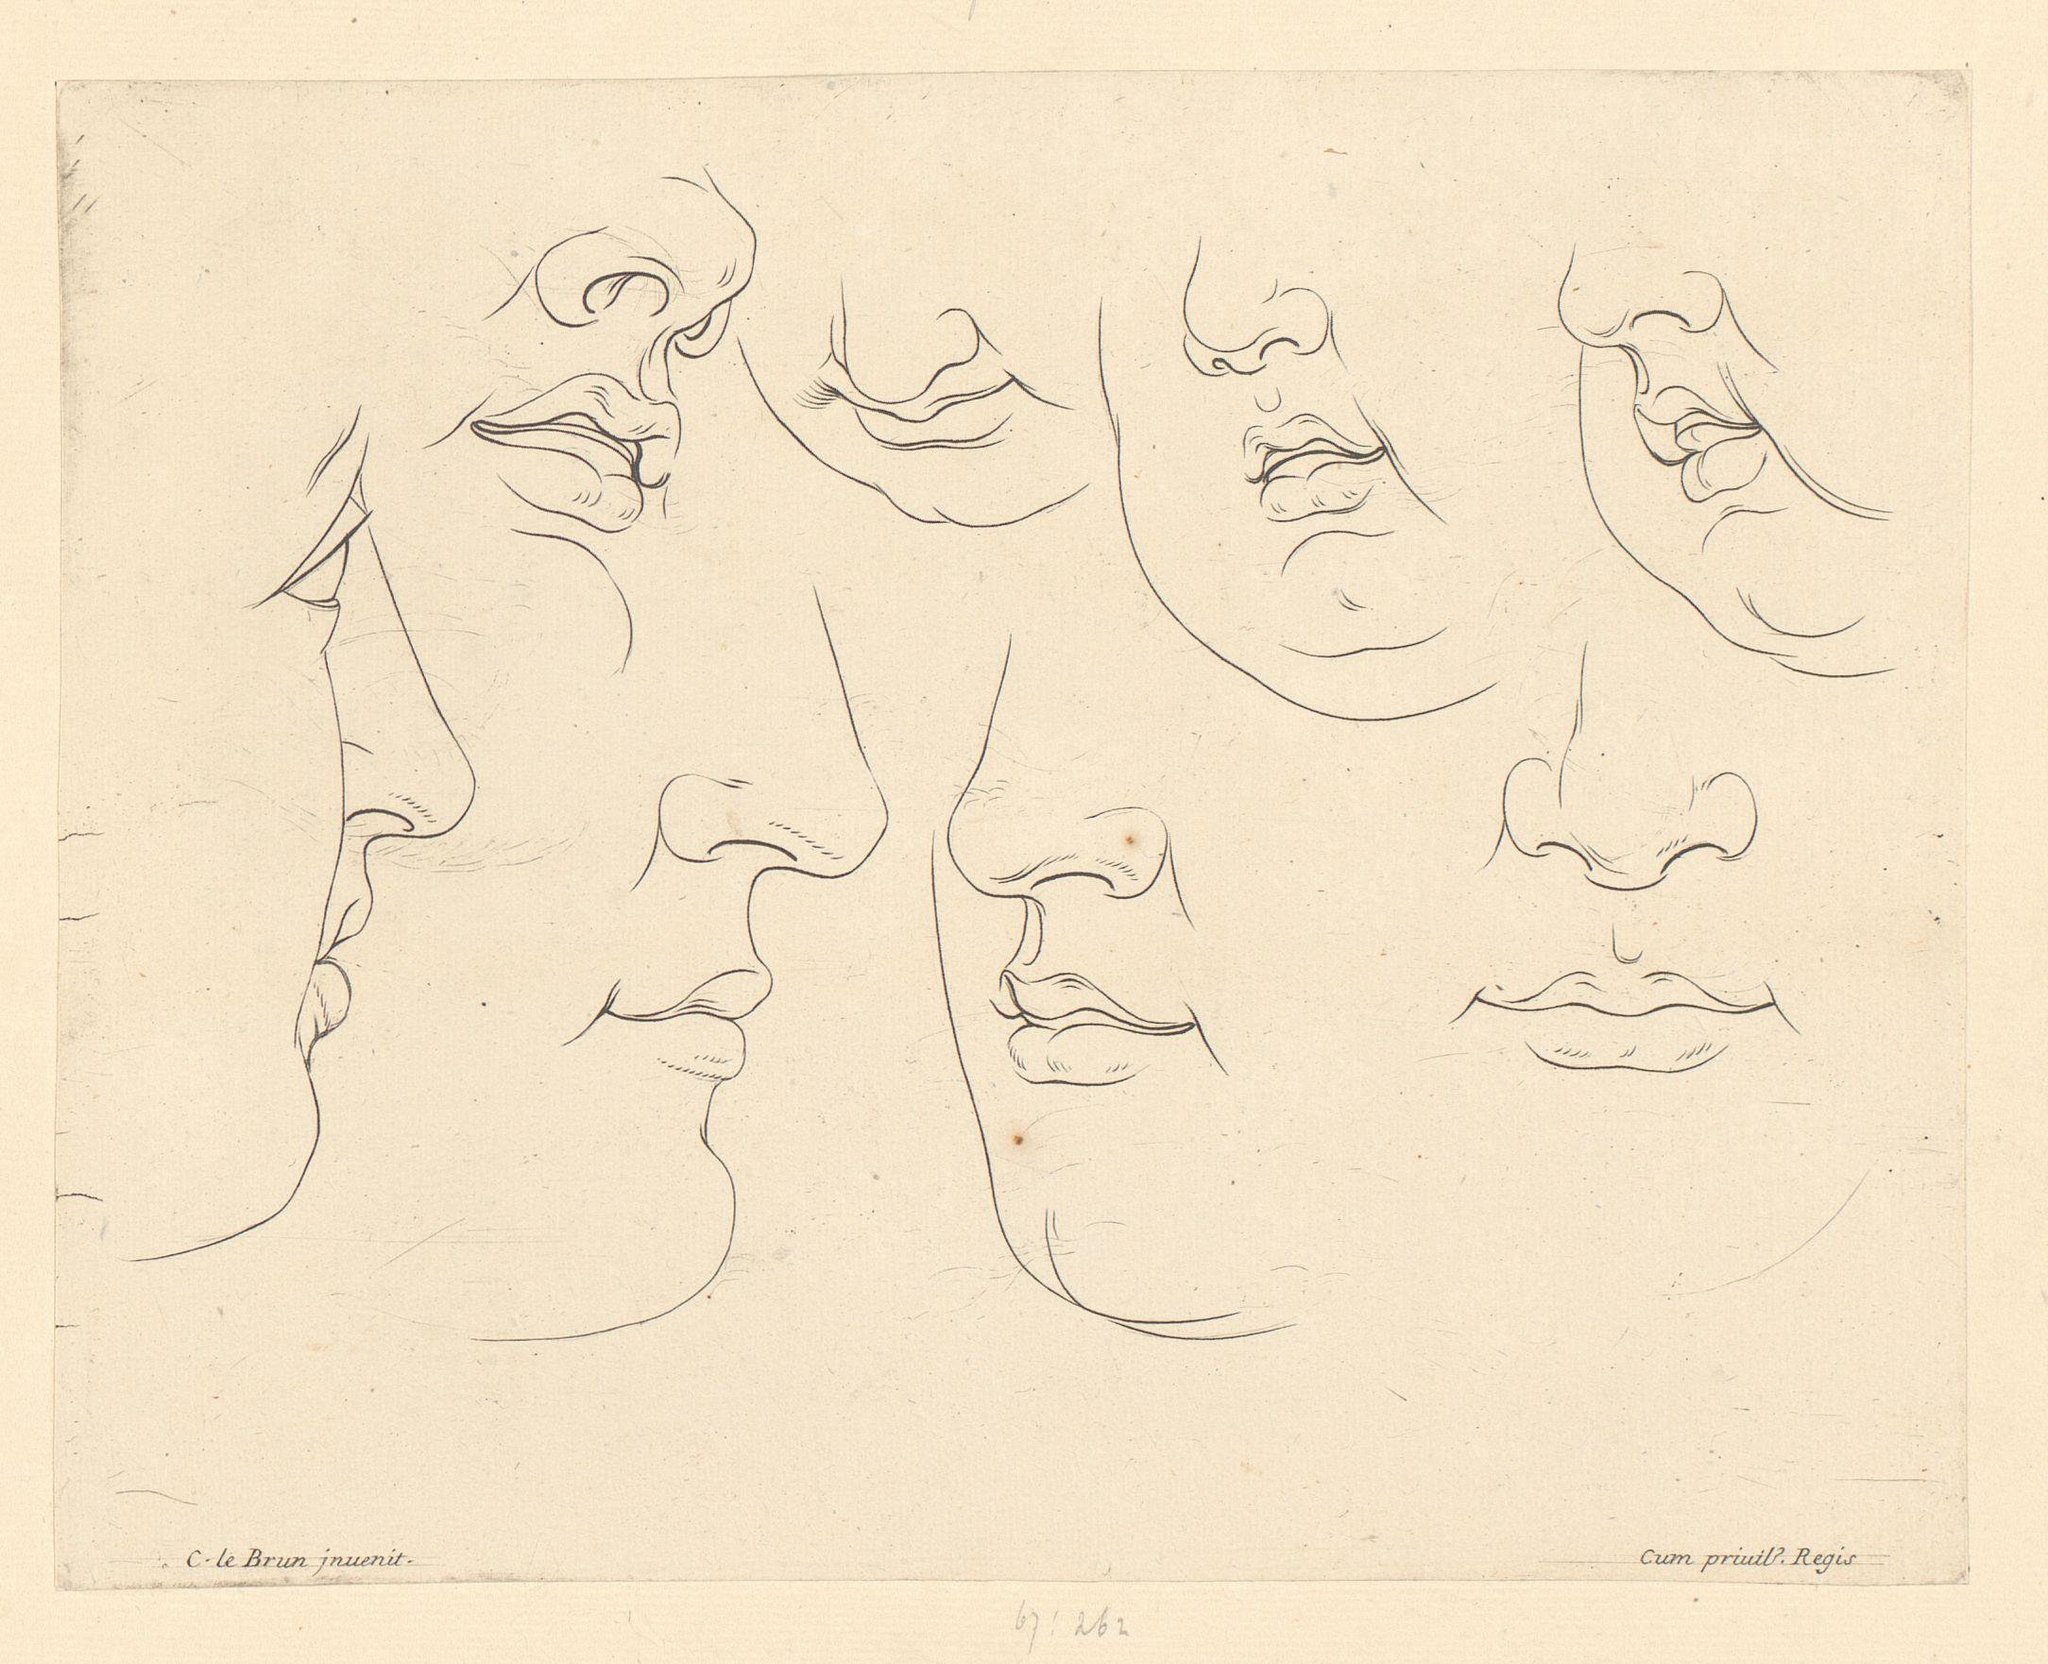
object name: album leaf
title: L'ouvrage de Charles le Brun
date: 1700-1725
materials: paper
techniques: etching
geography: paris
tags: face, morphology of facial expression ~ nose, morphology of facial expression ~ mouth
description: Deze prent maakt deel uit van de serie 'Livre de portraiture', die weer onderdeel is van de grotere reeks 'Oeuvre de Charles le Brun'.